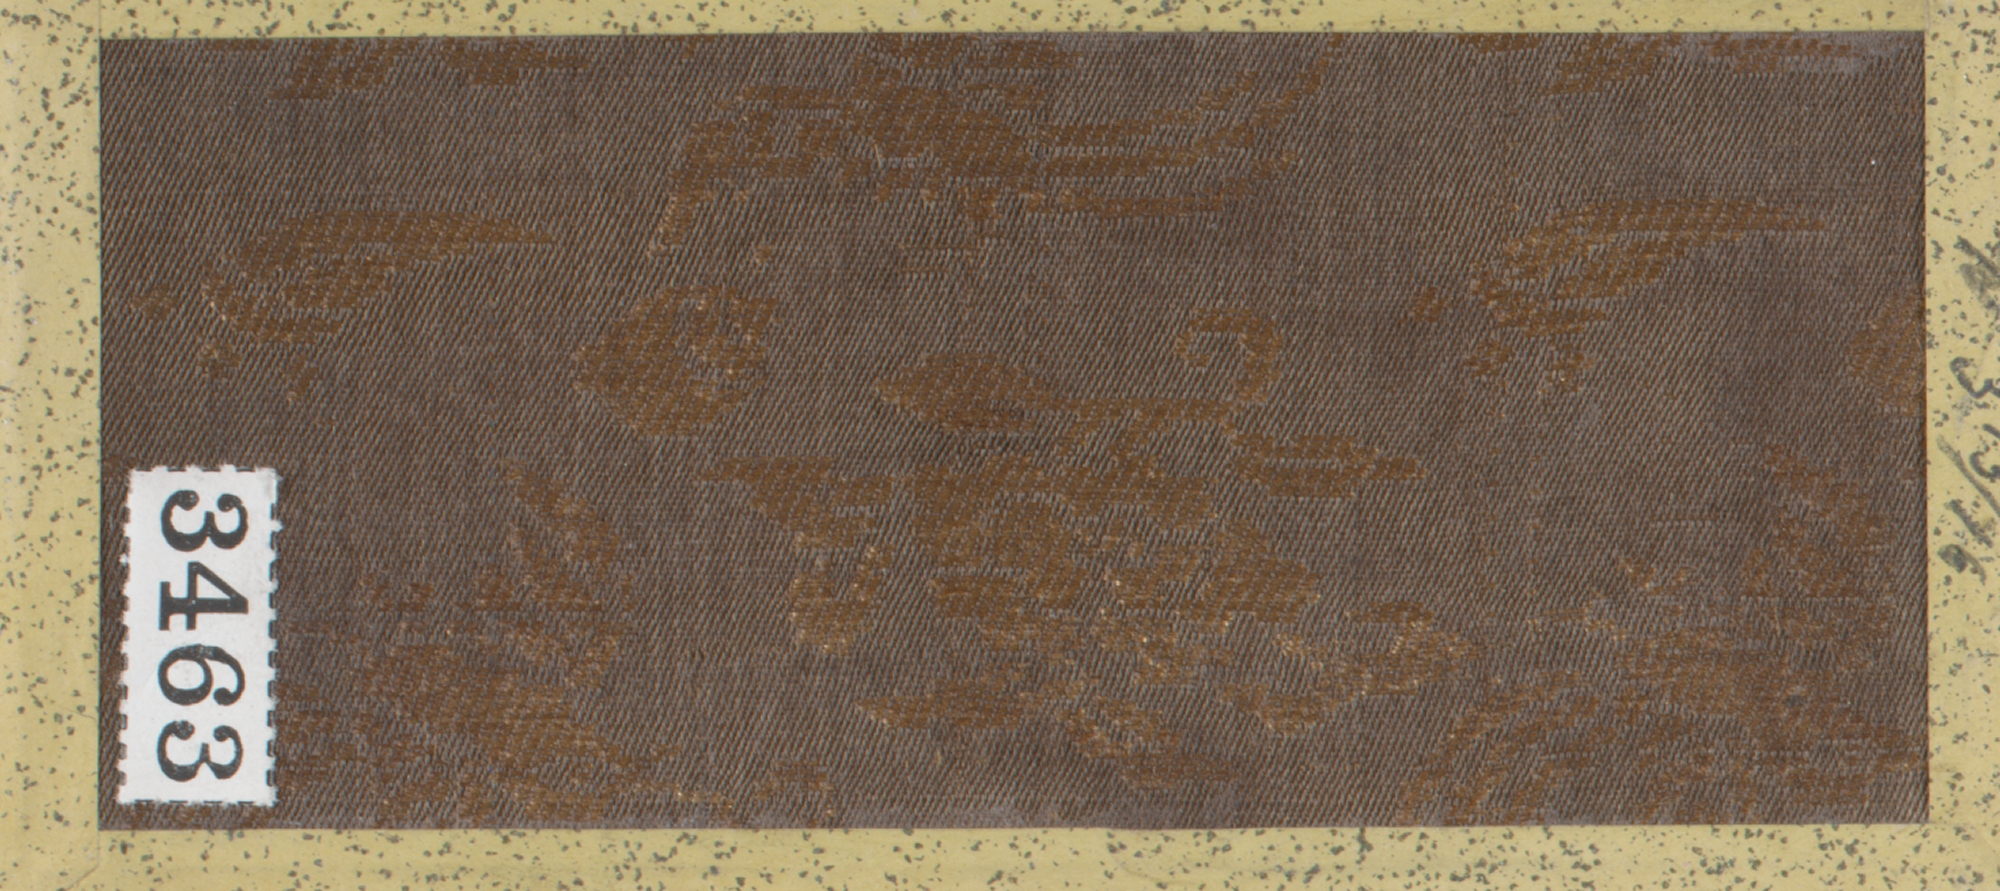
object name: sample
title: Textile Sample from Sample Book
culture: japanese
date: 1801-1900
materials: silk